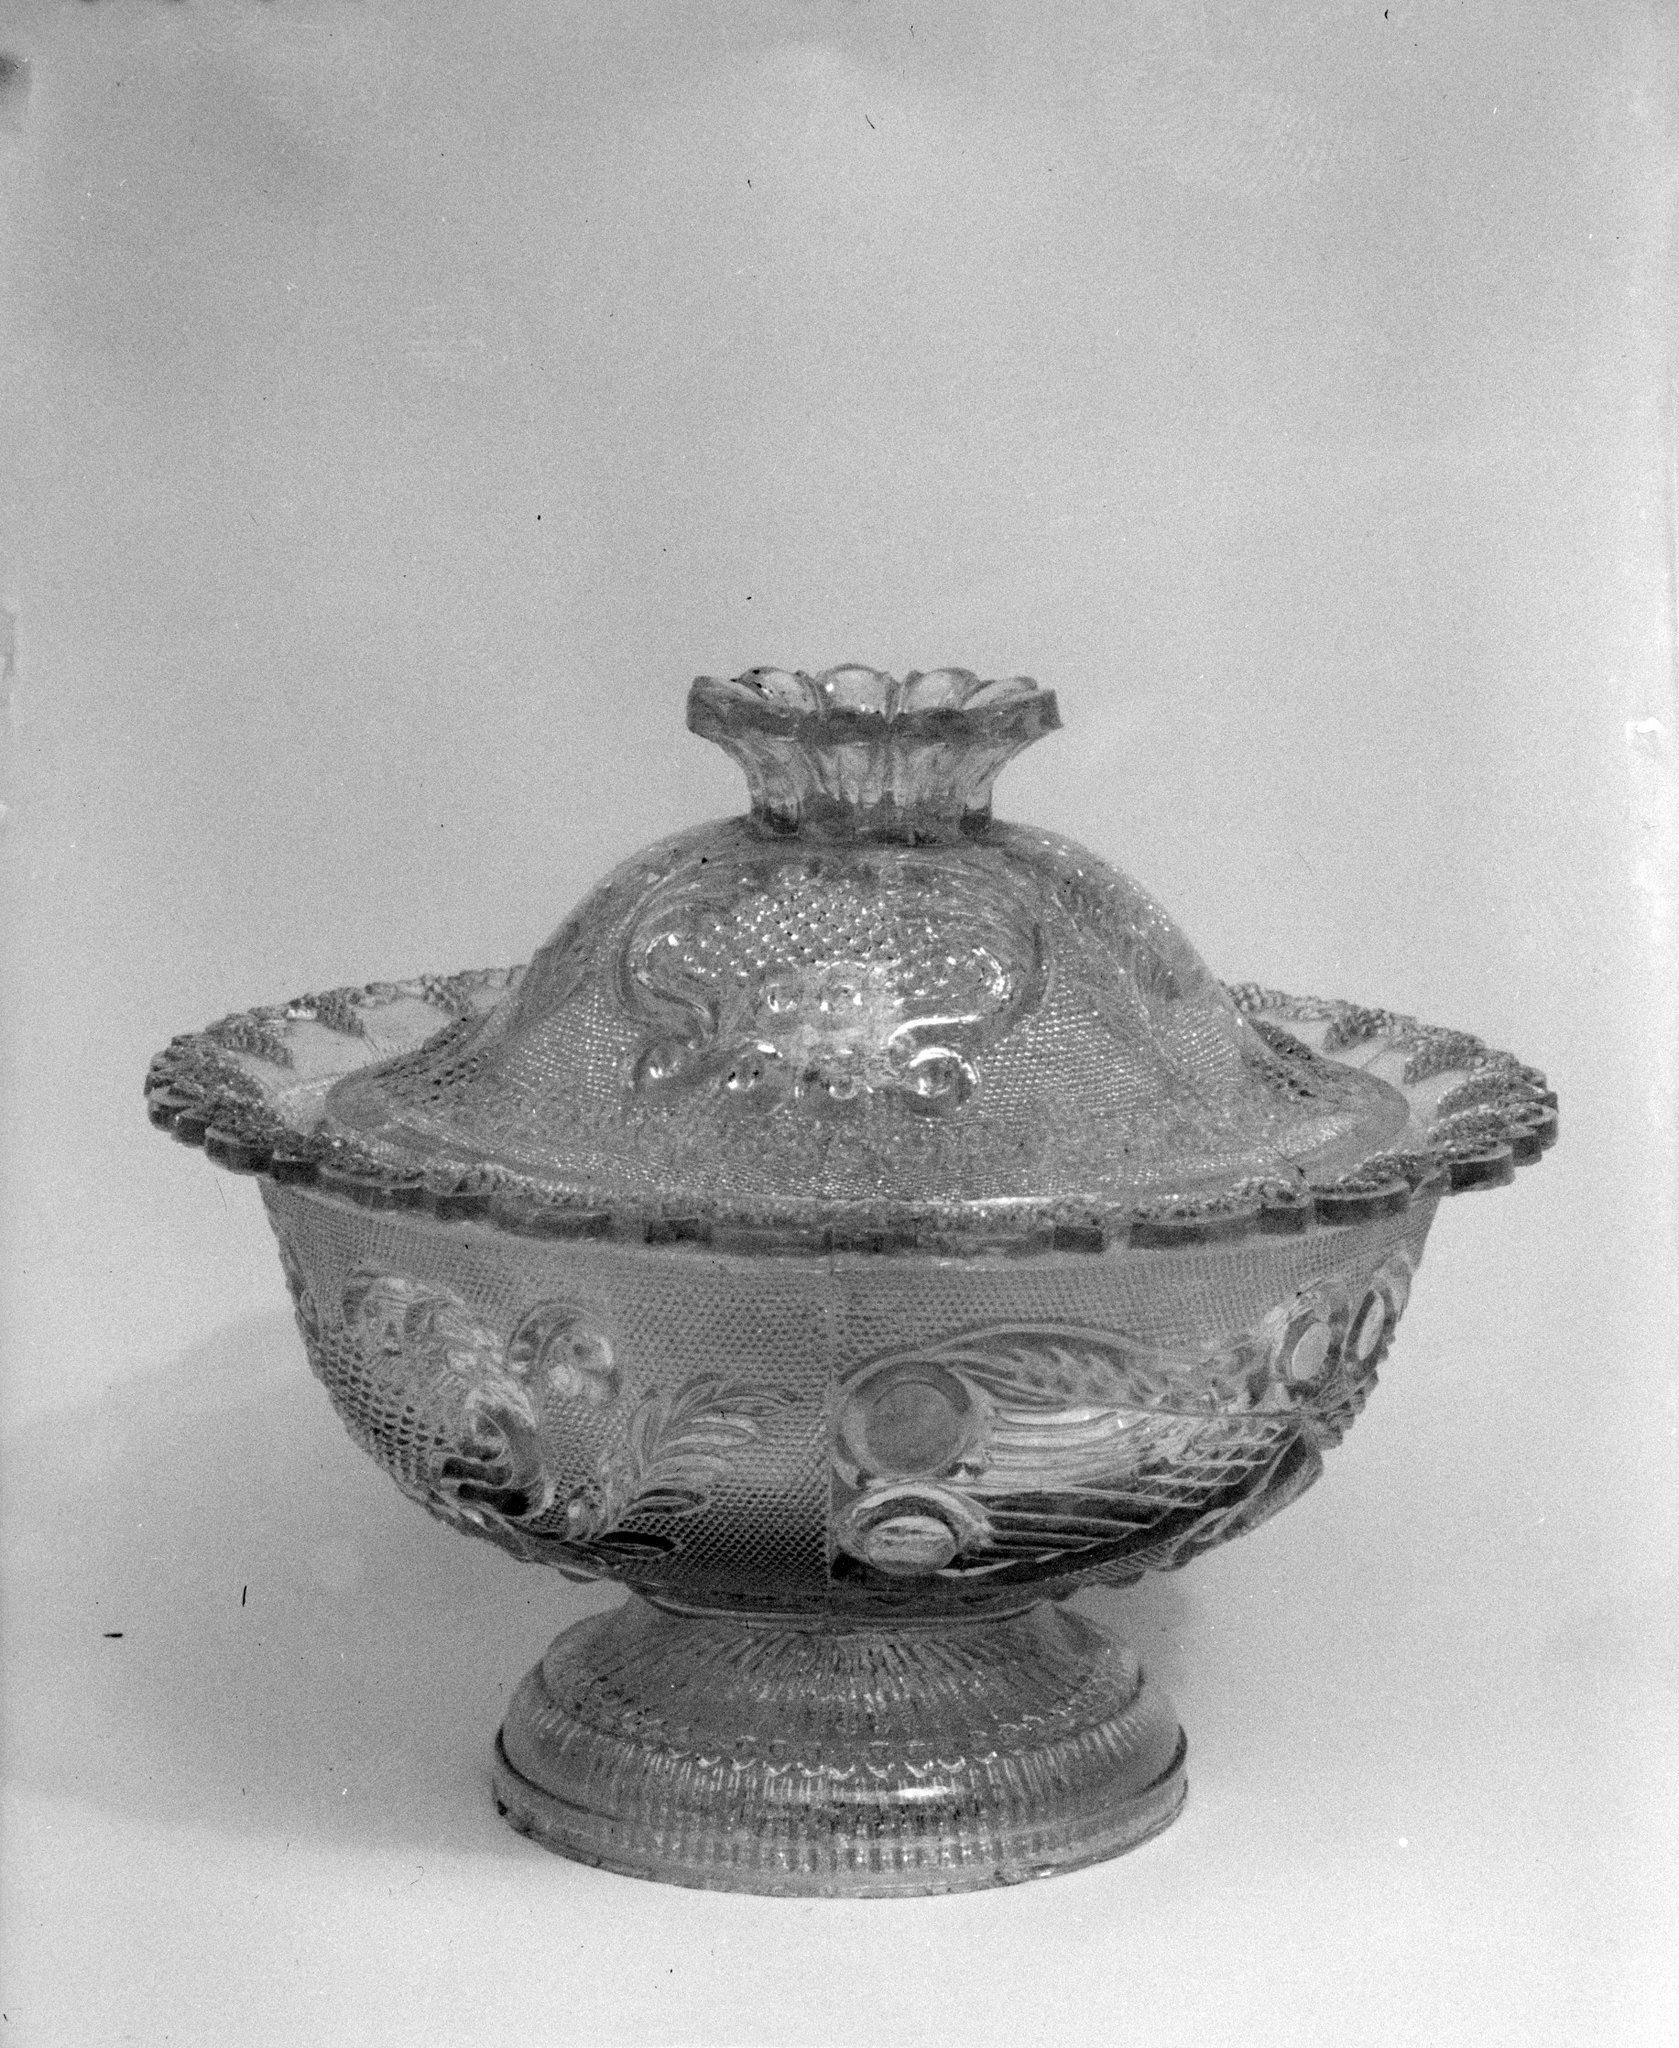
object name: bowl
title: Covered Bowl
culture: american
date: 1840-1875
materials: glass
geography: united states